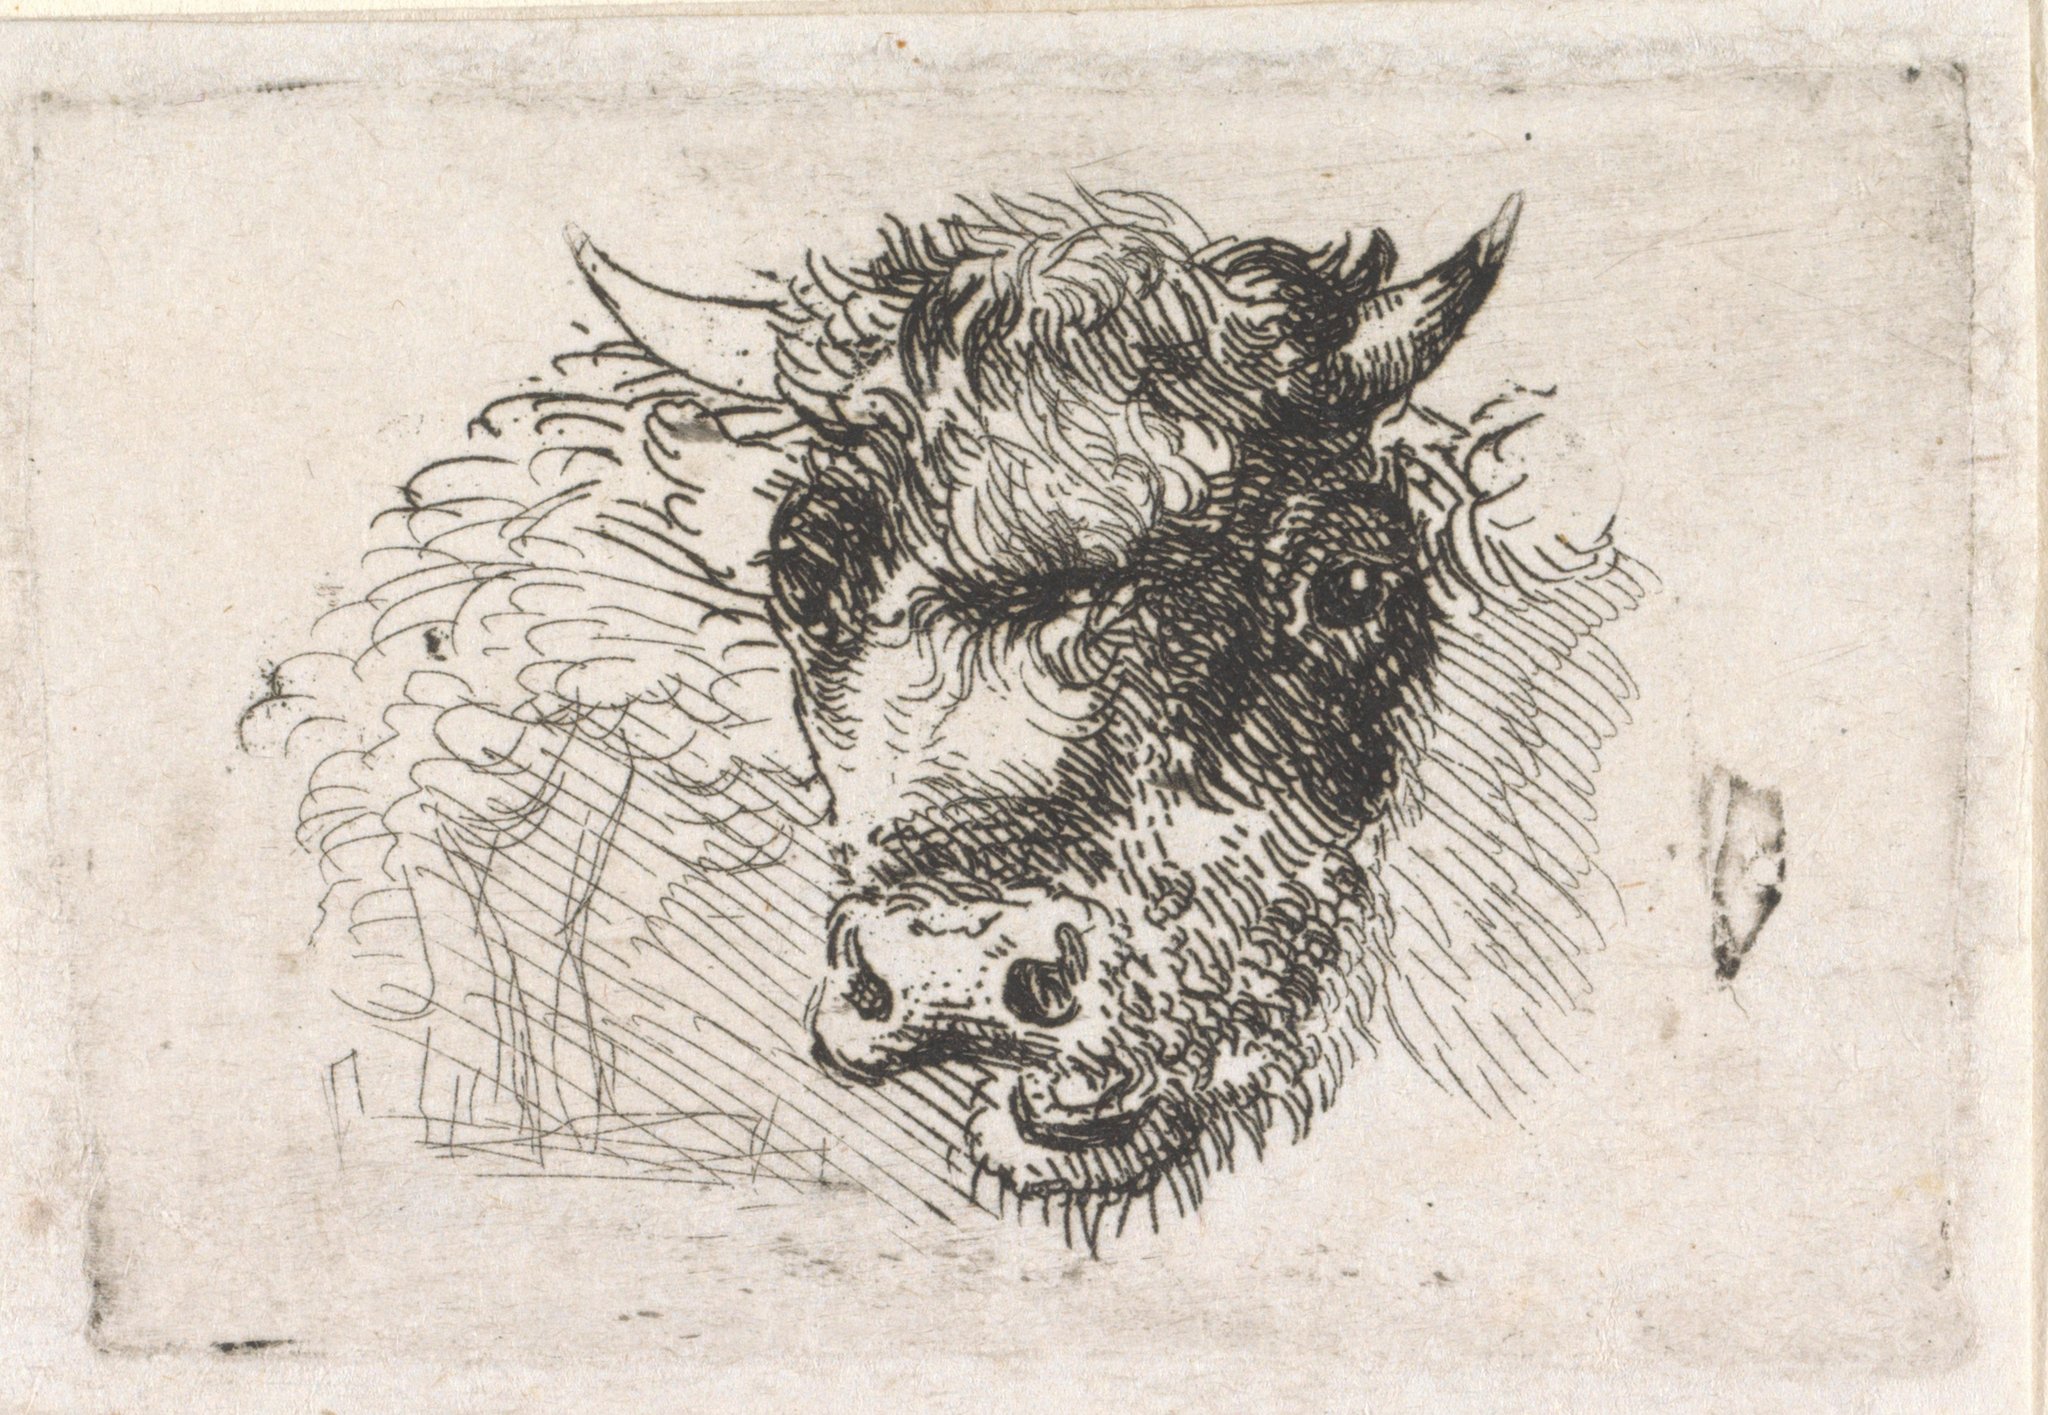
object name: print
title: Koeienkop en schapenkop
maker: Anonymous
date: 1700-1850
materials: paper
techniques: etching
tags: cow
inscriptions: collector's mark: Lugt 2228